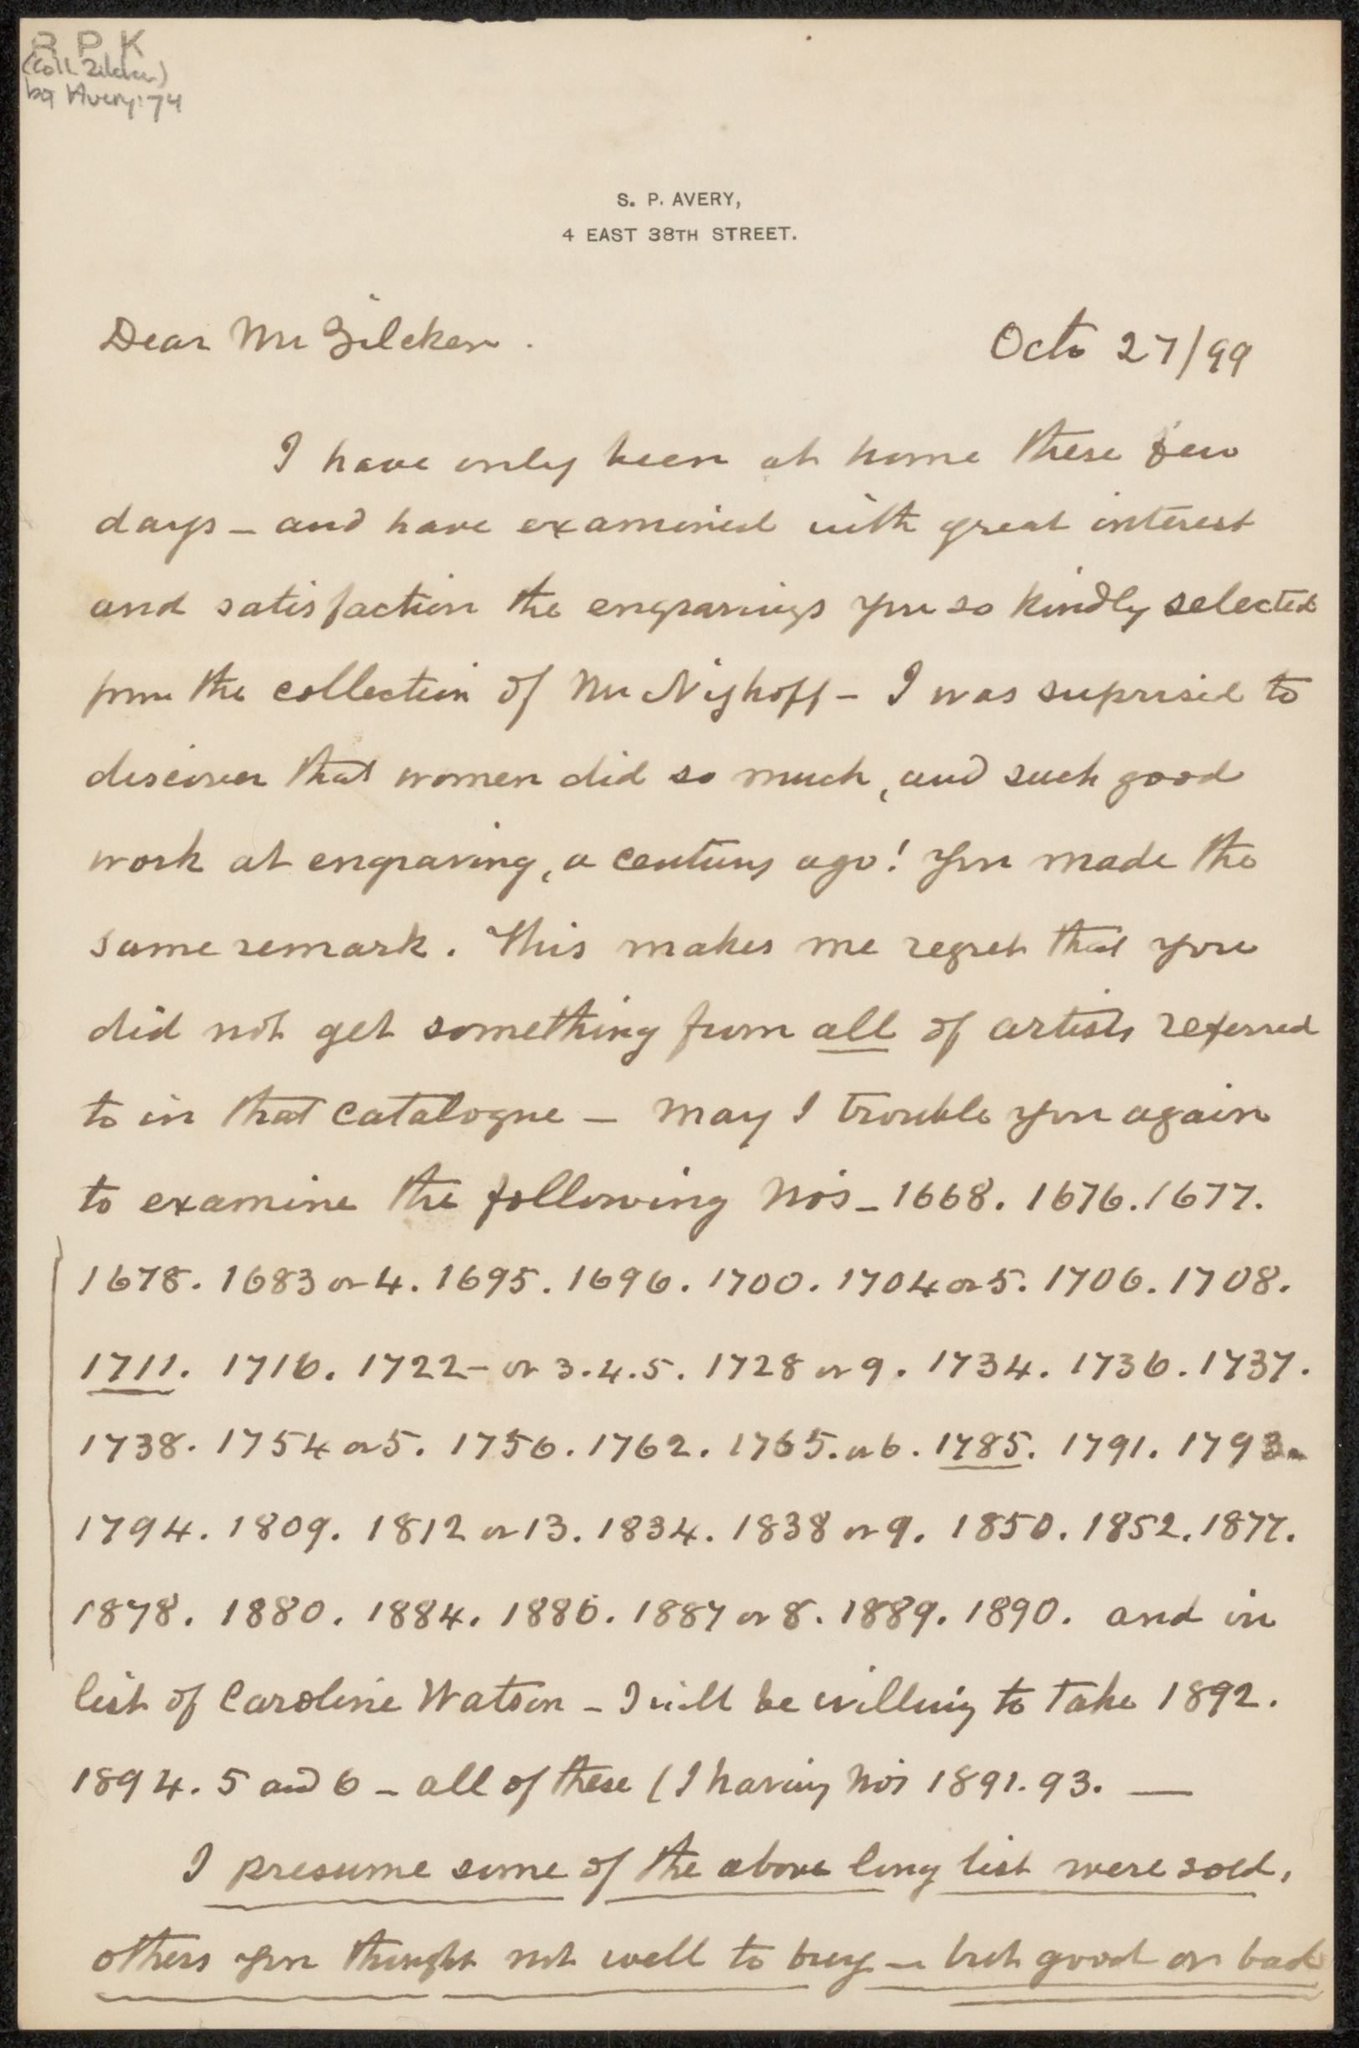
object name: letter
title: Brief aan Philip Zilcken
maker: samuel putnam avery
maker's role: verzamelaar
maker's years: 1822-1904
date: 1899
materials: ink, paper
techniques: pen, printing, writing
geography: new york city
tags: arnhem, publisher, martinus nijhoff, painter, draughtsman, philip zilcken, art trade, art shop, the graphic arts, art collecting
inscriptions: collector's mark: ‘RPK’